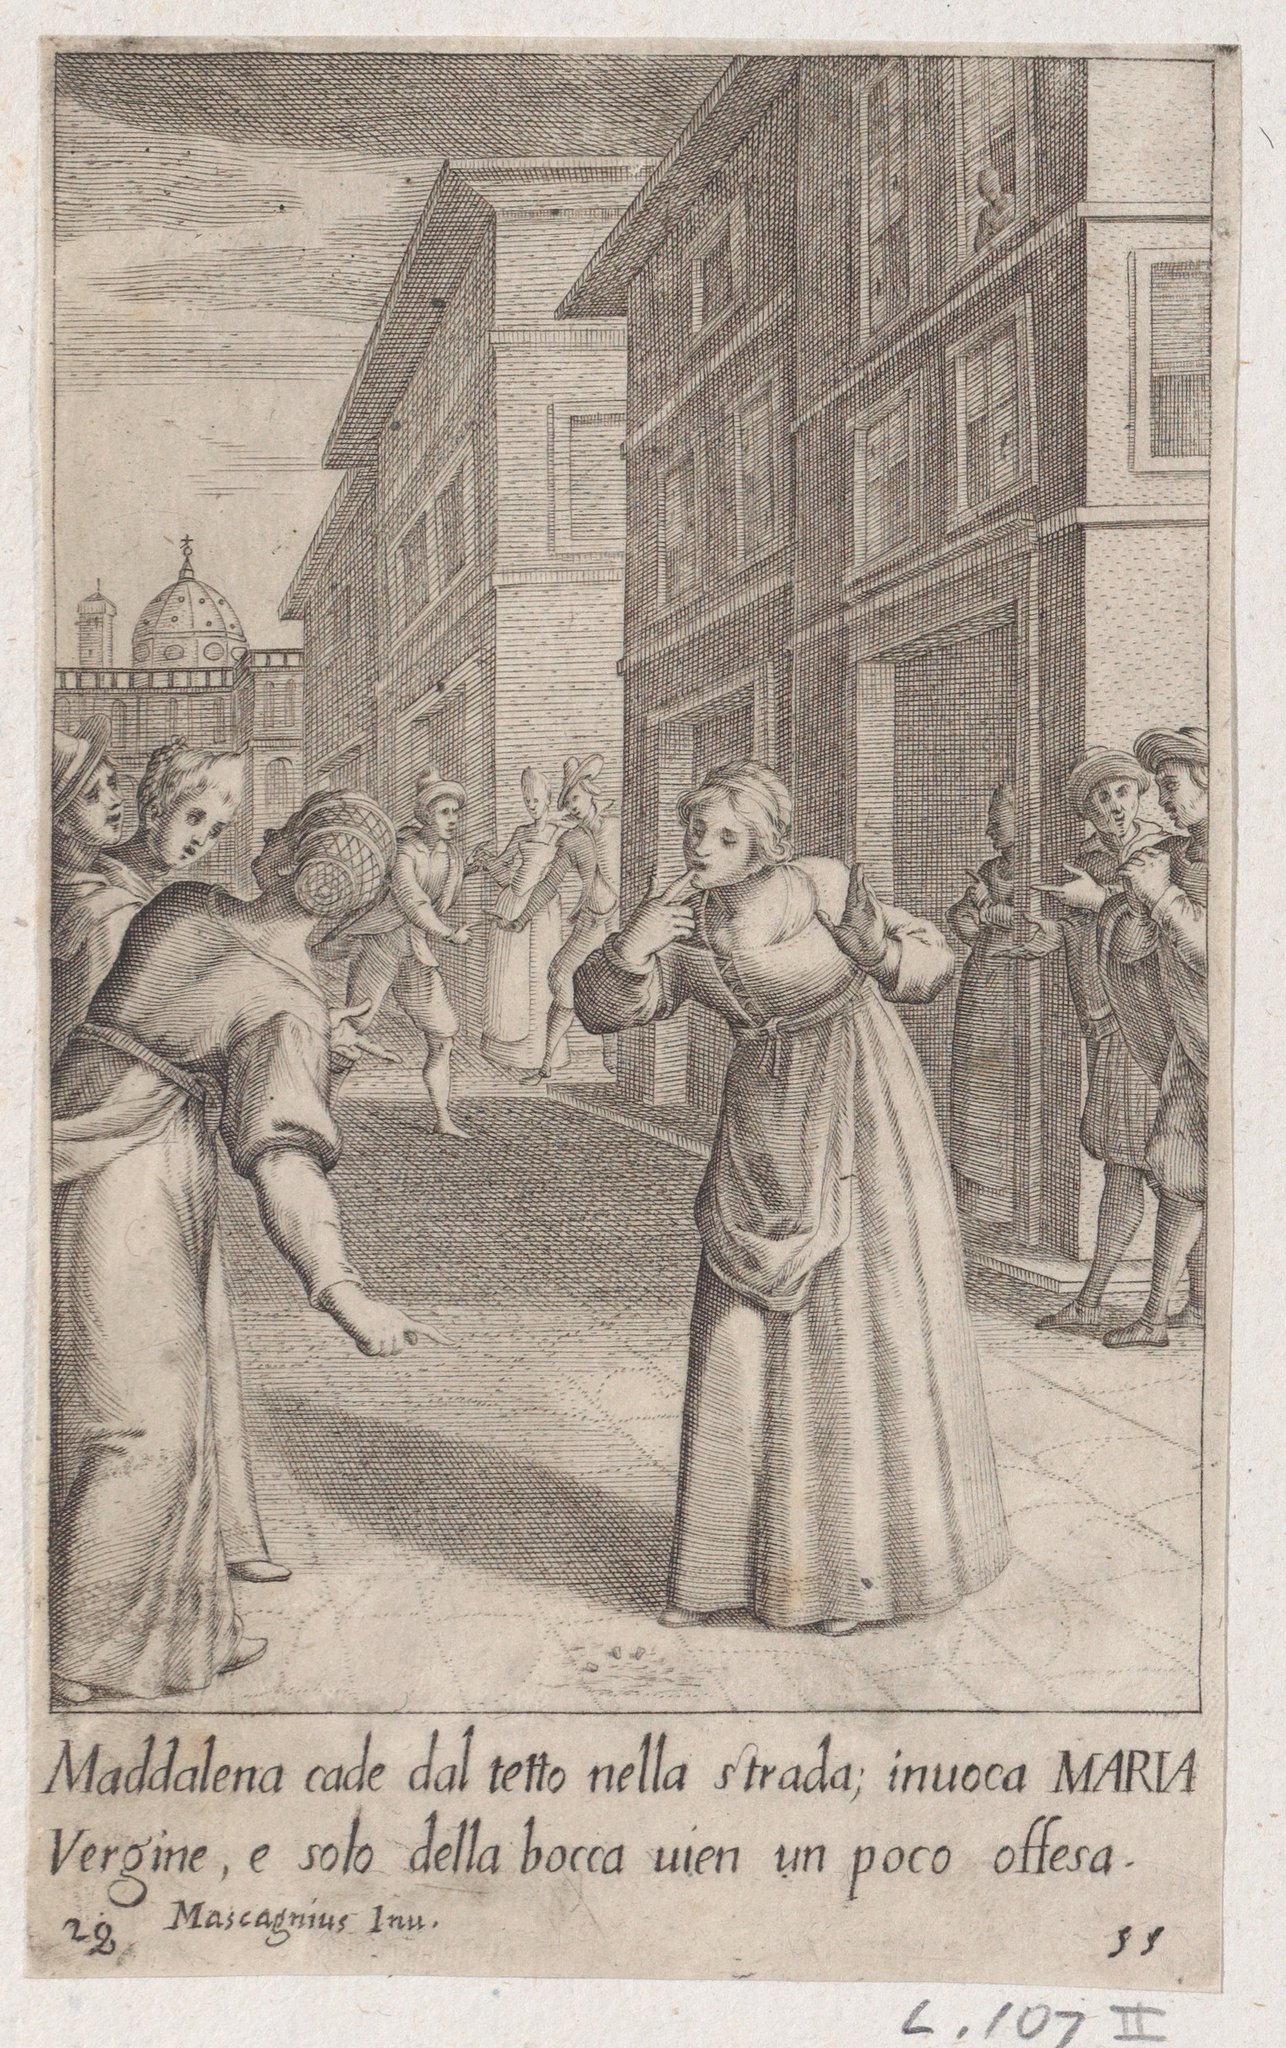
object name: print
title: Maddalena, from Scelta d'Alcuni Miracoli e Grazie della Santissima Nunziata di Firenze (Selection of Some Miracles and Graces that Occurred in the Church of the Annunziata in Florence)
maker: jacques callot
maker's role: artist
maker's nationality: french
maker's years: 1592-1635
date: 1611-1619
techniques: engraving